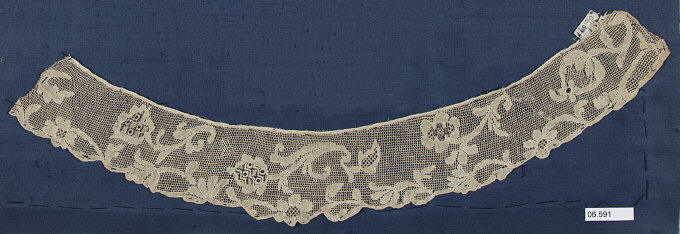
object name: cuff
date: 1701-1800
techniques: embroidery